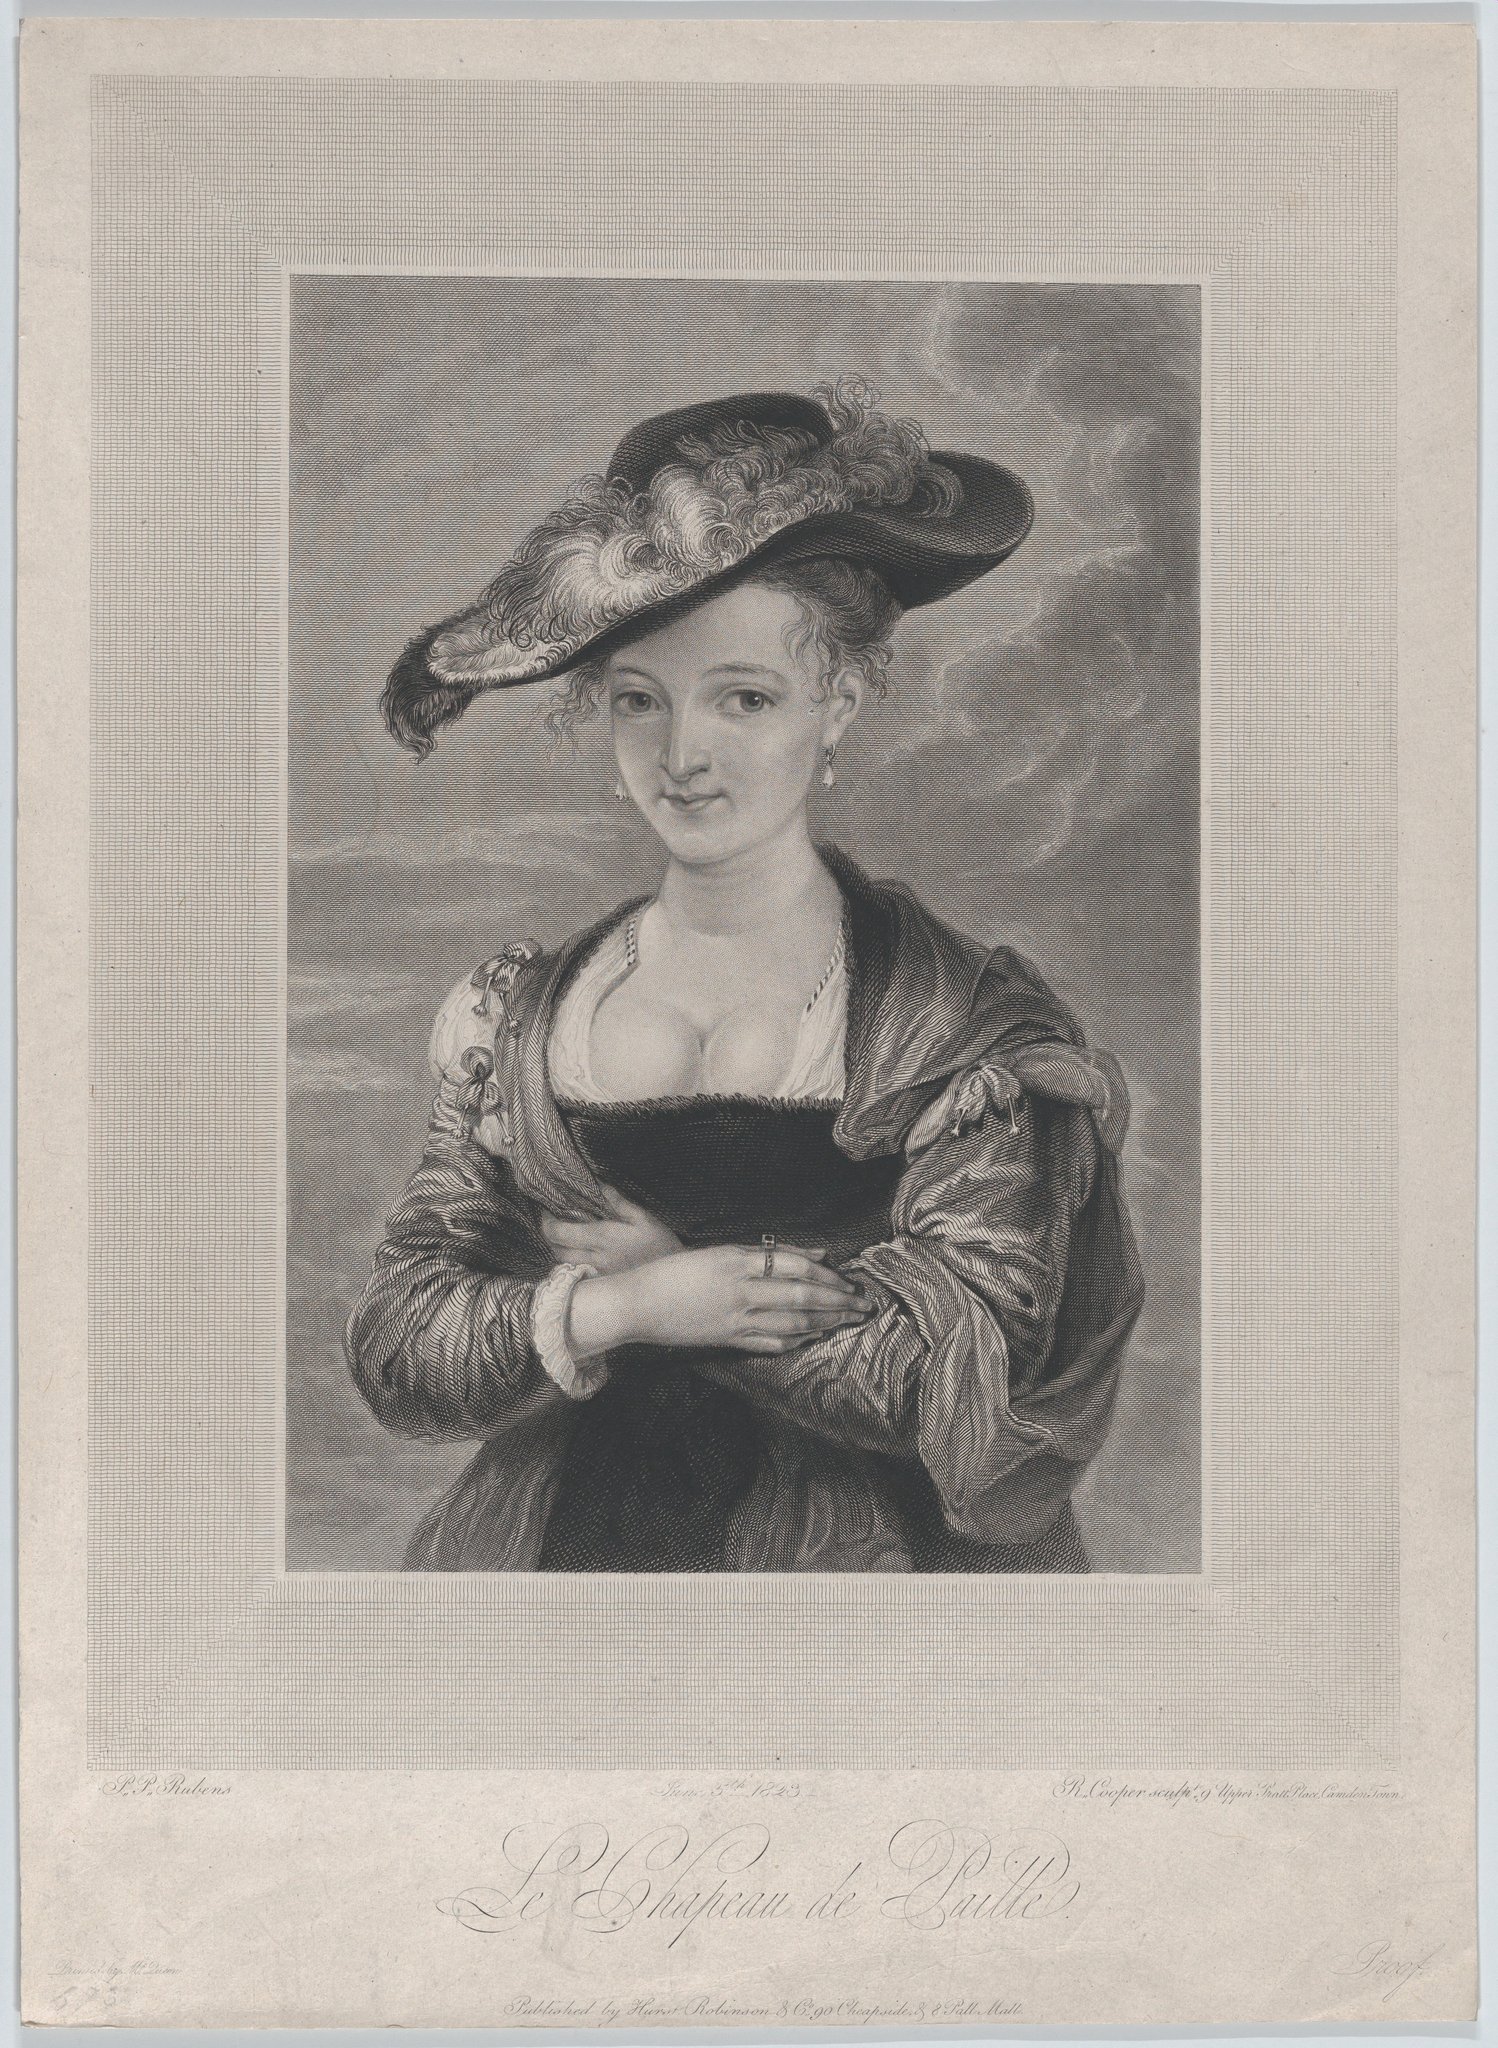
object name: print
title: The Straw Hat (Le Chapeau de Paille), Portrait of Susanna Lunden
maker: robert cooper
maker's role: artist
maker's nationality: british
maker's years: -1828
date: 1823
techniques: engraving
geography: paris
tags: portraits,women